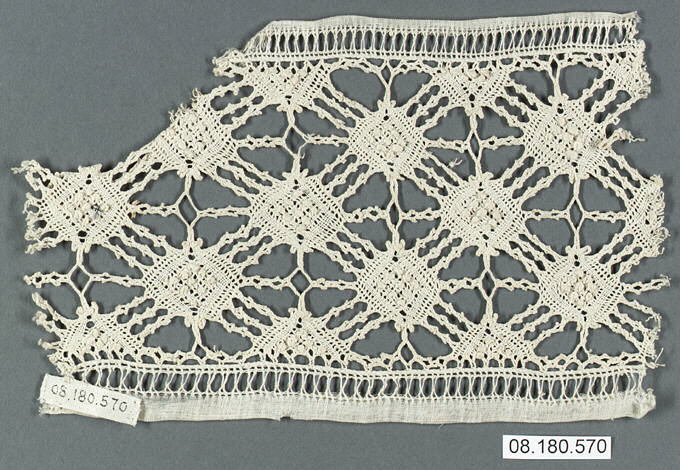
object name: insertion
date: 1701-1800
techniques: lace, embroidery